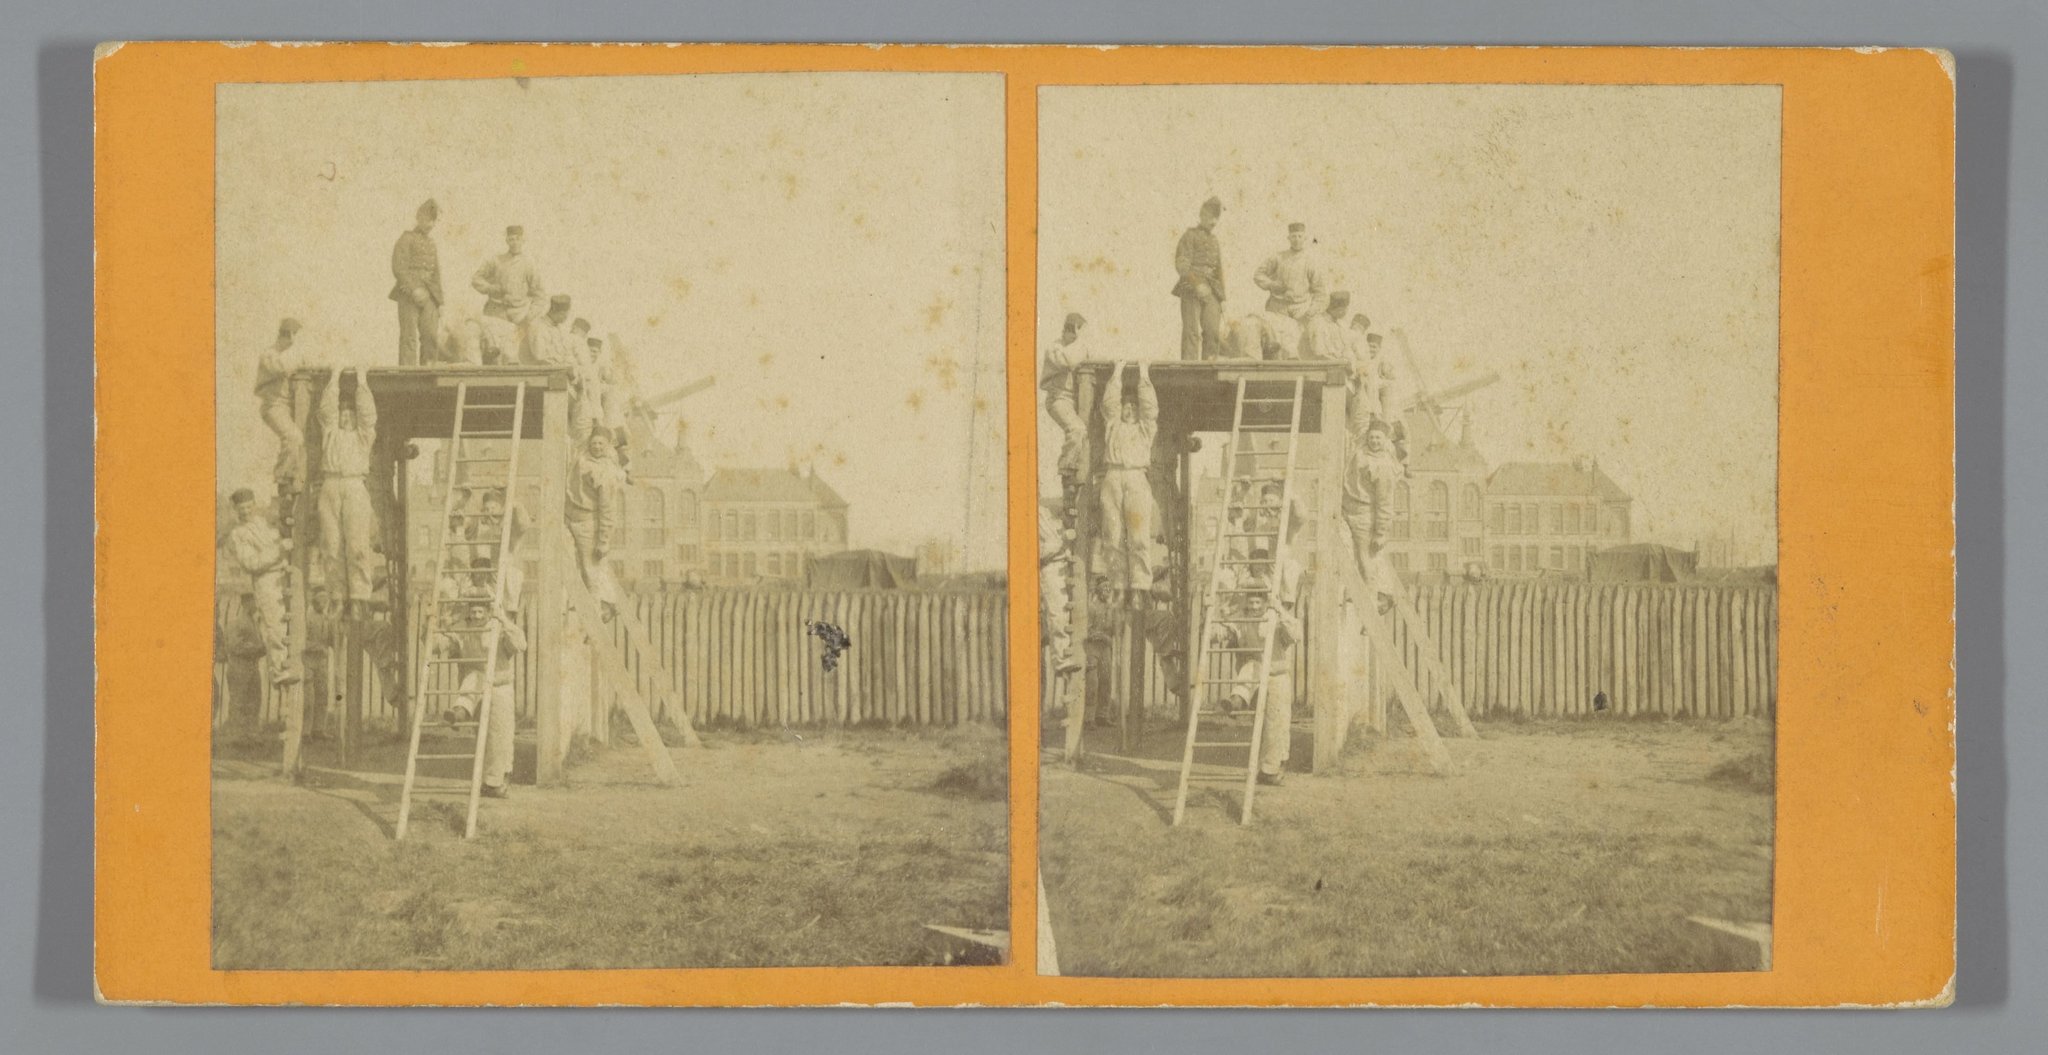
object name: stereograph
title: Amsterdam plaats Oranje-Nassau kazerne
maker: Anonymous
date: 1866-1870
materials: cardboard, paper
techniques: albumen print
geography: amsterdam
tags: drill ~ military training, athletics, gymnastics